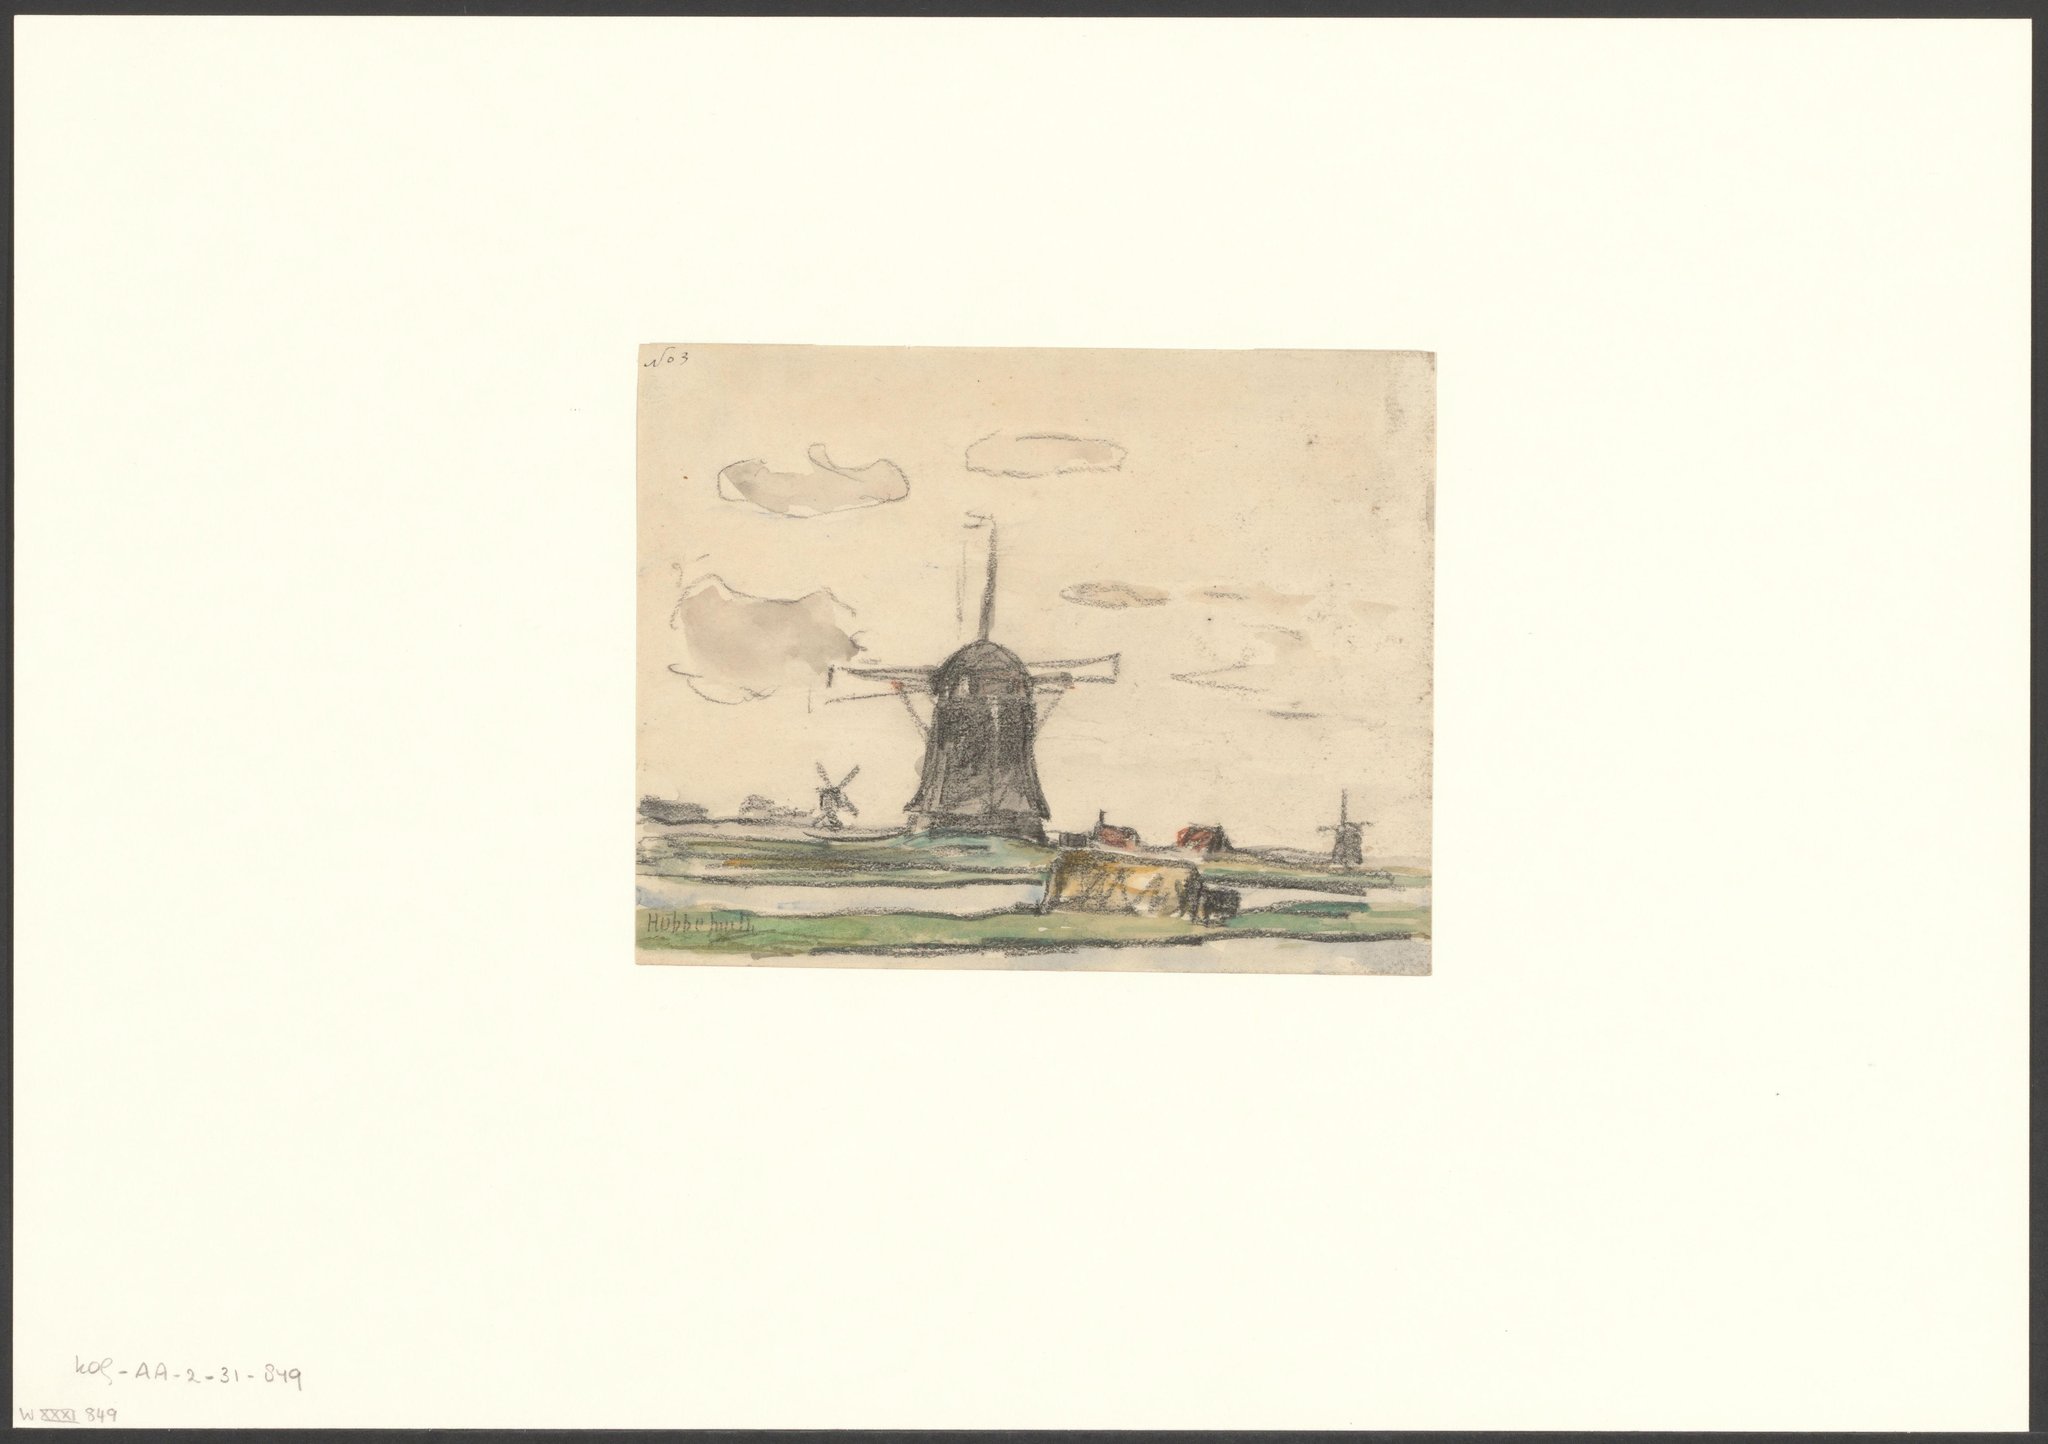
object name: drawing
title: Gezicht op de Koenenmolen aan de Nieuwe Meer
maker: hobbe smith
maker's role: painter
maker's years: 1862-1942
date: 1872-1919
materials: chalk, paper, watercolor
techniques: brush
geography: amsterdam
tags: city-view in general; 'veduta', lake, windmill in landscape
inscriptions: signature: ‘HobbeSmith’, collector's mark: Lugt 800a, inscription: ‘Koene molen’, number: ‘No 3’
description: Tekening binnen de Atlas Van Eck ingedeeld op wijknummer 31.